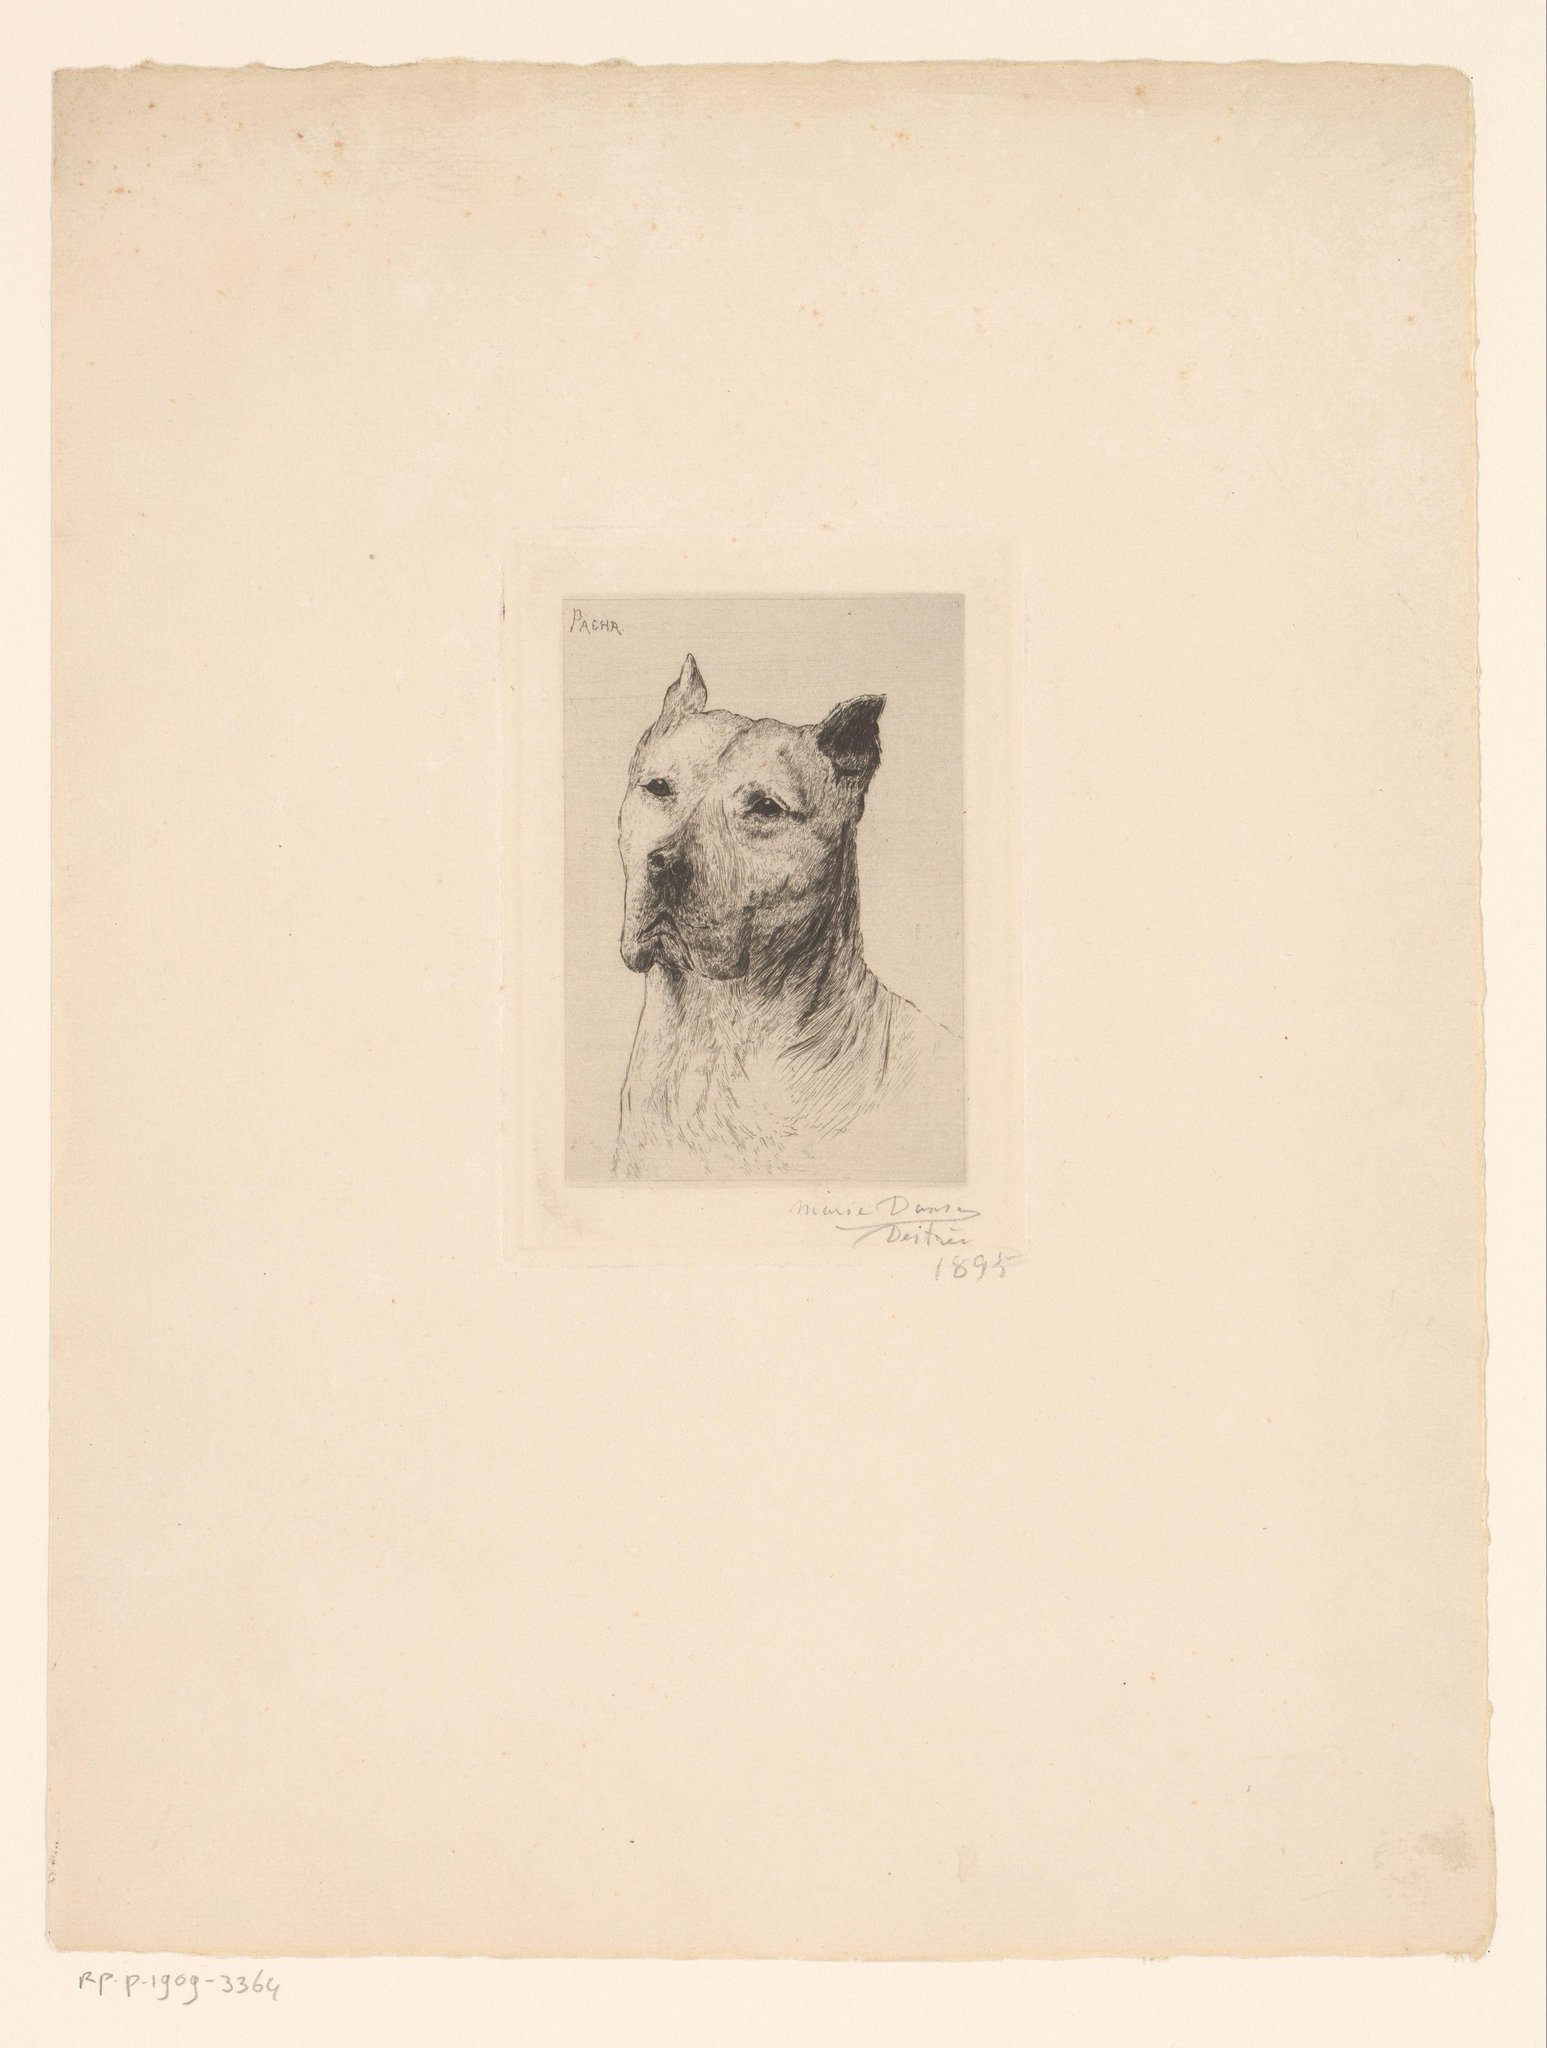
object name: print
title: Portret van hond Pacha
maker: marie danse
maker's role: print maker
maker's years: 1867-1942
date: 1894-1895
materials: paper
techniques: etching, intaglio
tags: historical persons, dog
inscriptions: collector's mark: Lugt 2228, inscription